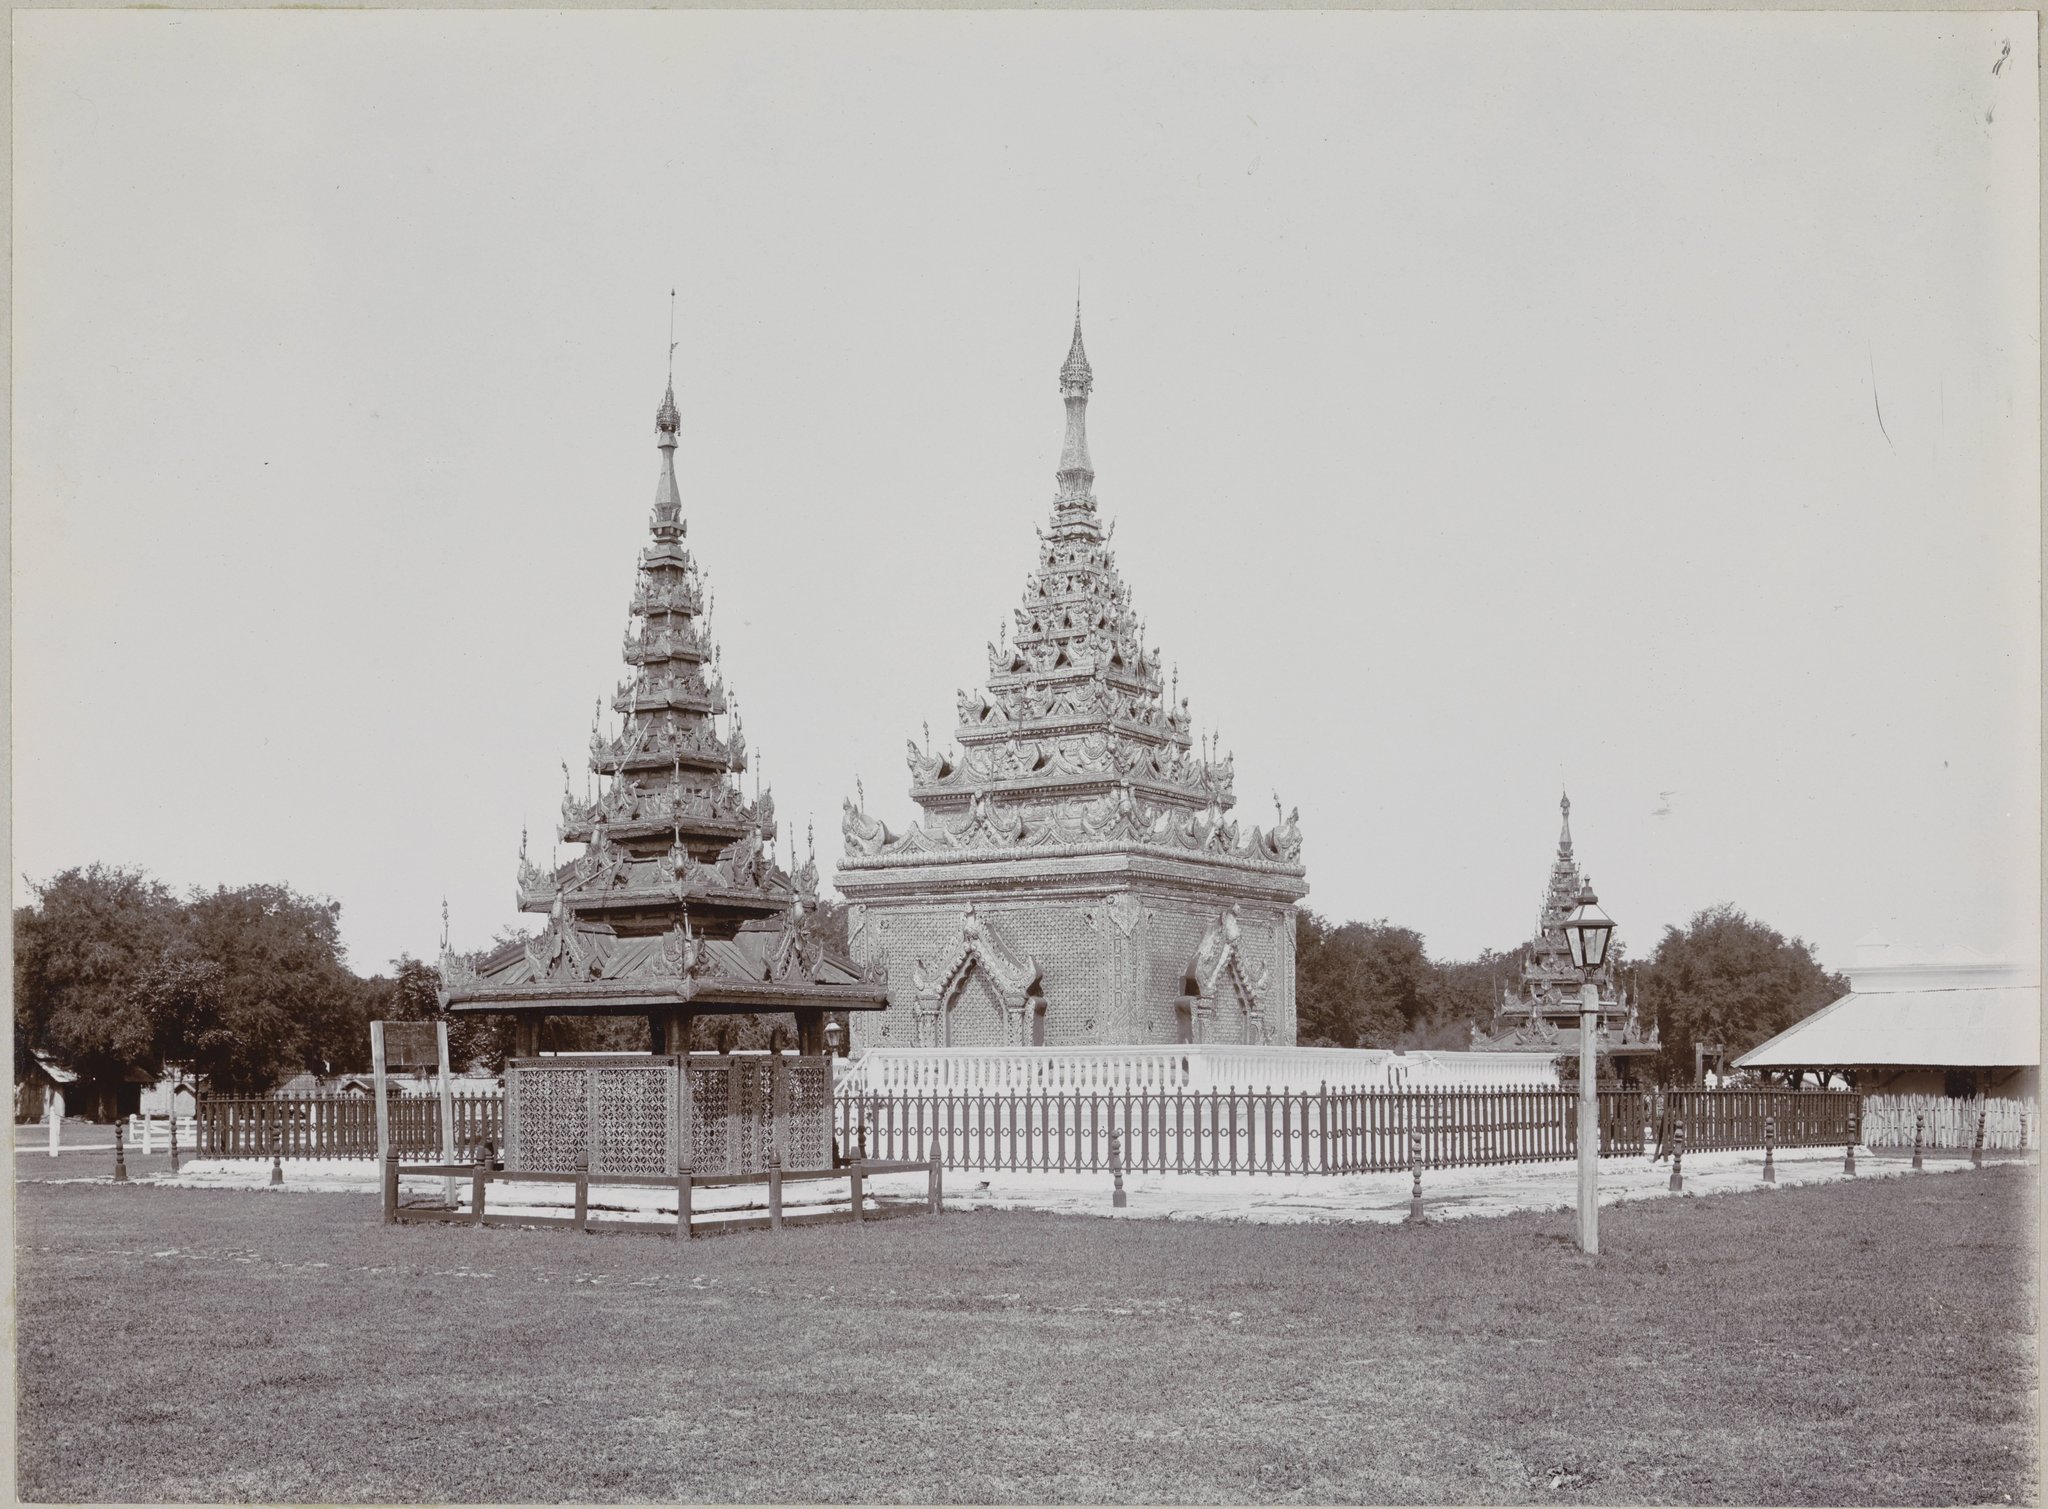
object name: photograph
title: Tomb of King Mindon in the palace of Mandalay, Myanmar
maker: Anonymous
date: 1895-1915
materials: cardboard, paper, photographic support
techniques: collodion silver print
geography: mandalay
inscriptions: inscription: ‘14. Graf v/een Koning en Witte Olifant/ (Mandalay)’